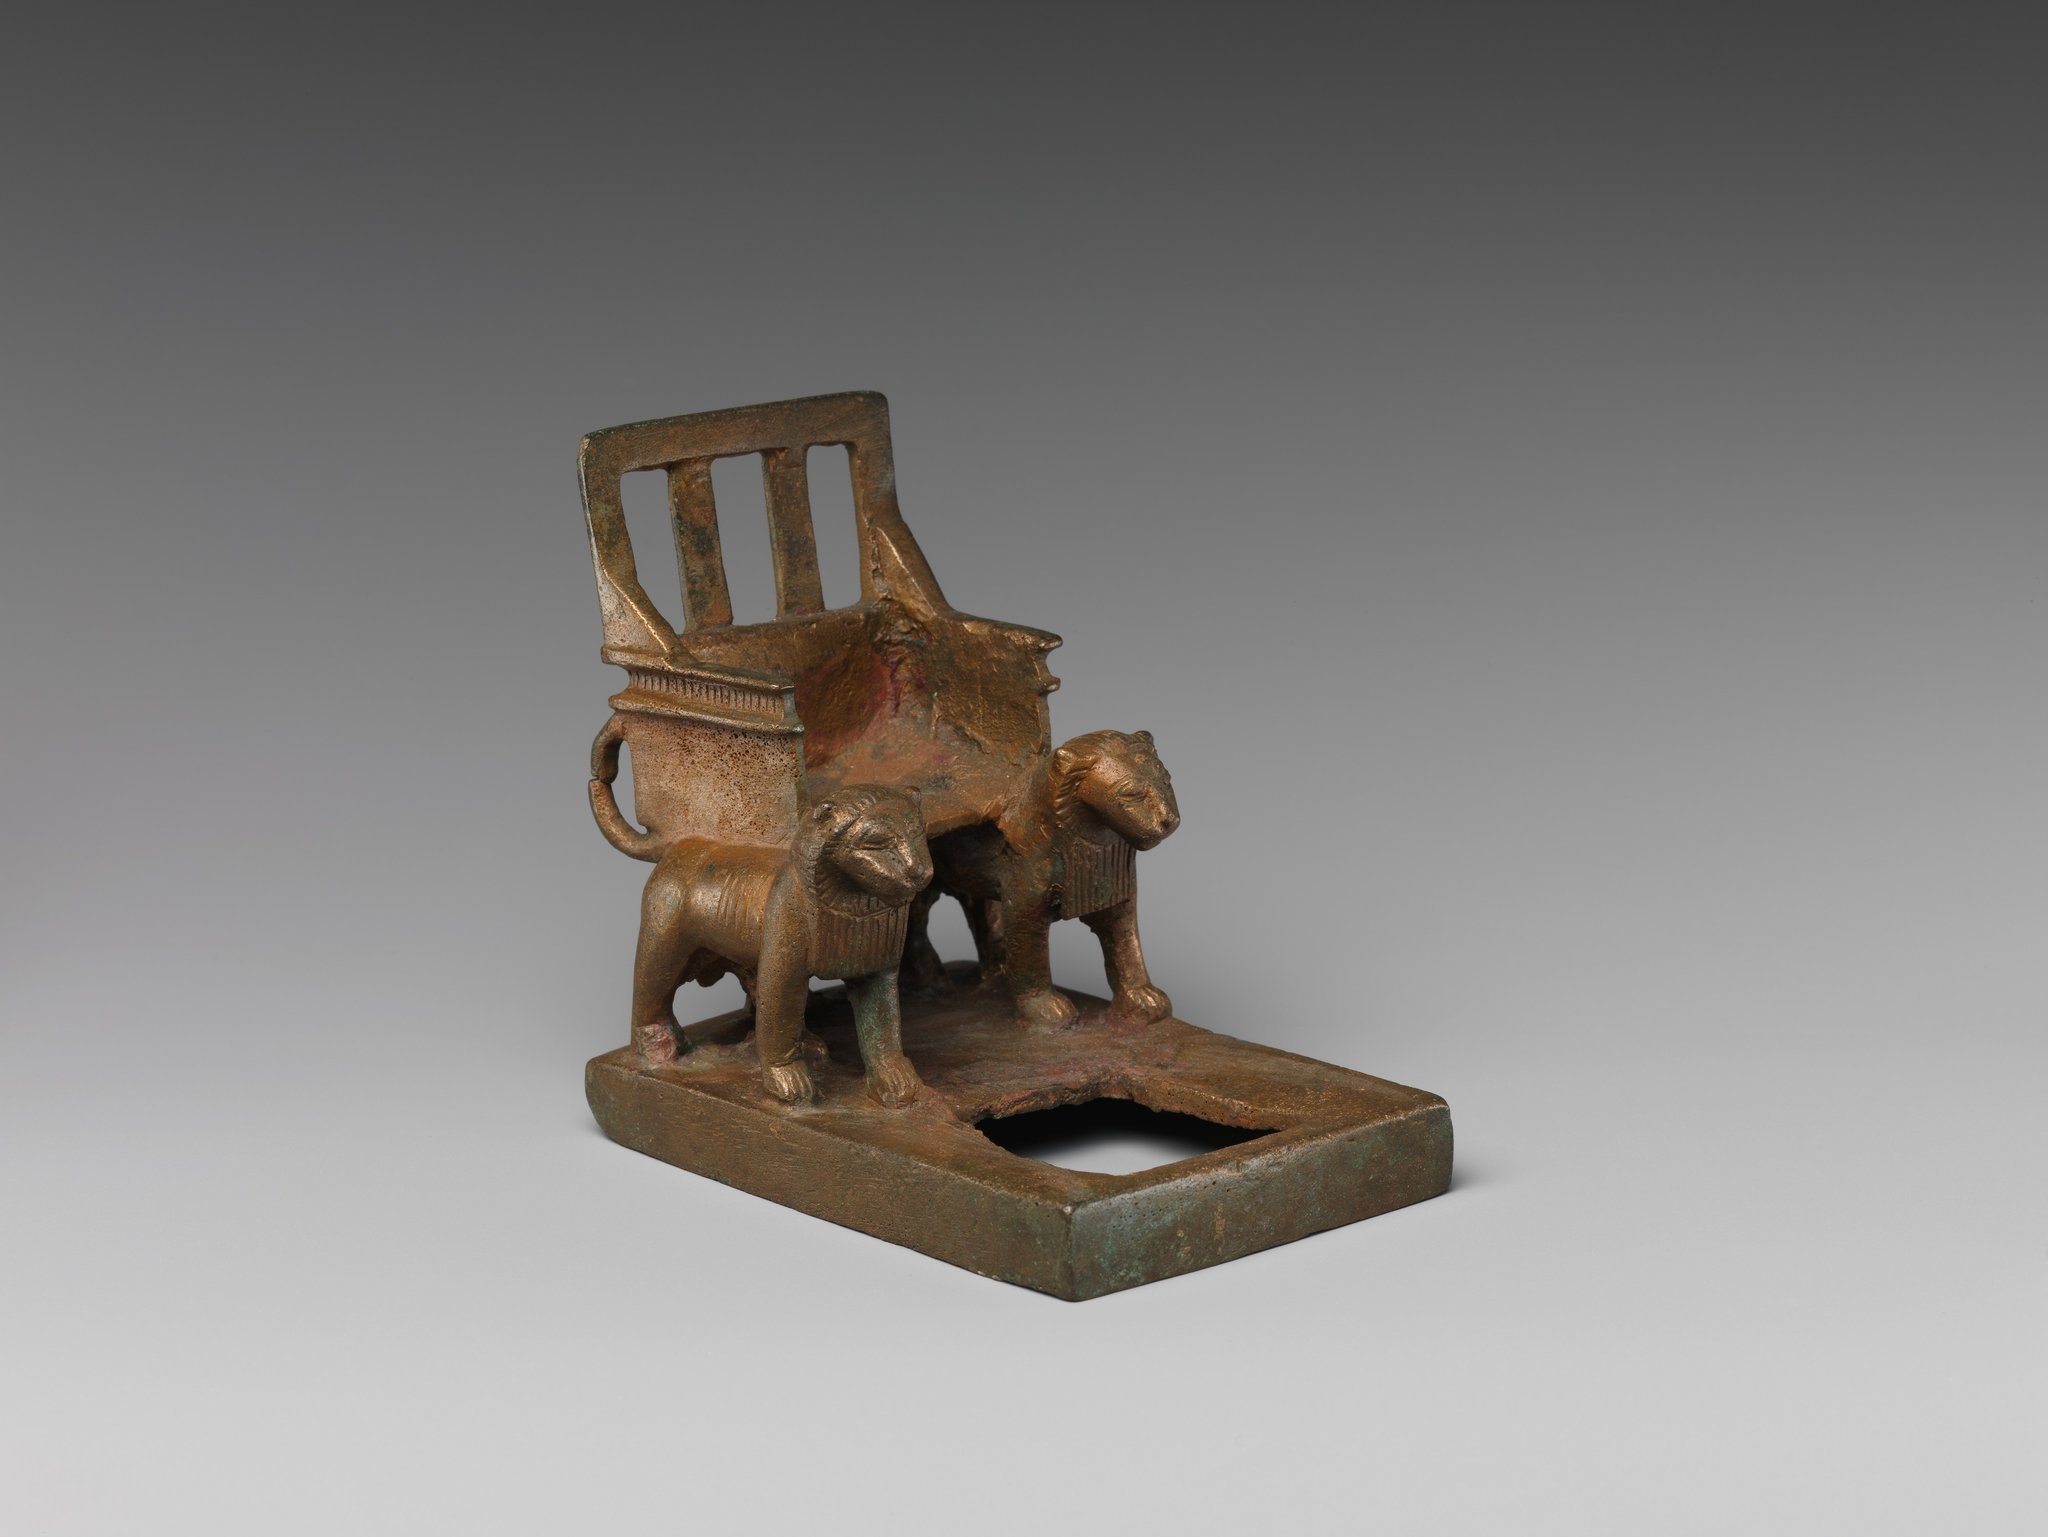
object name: throne for god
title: God's throne supported by two striding lions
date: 332-330 BCE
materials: metal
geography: egypt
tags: lions,chairs